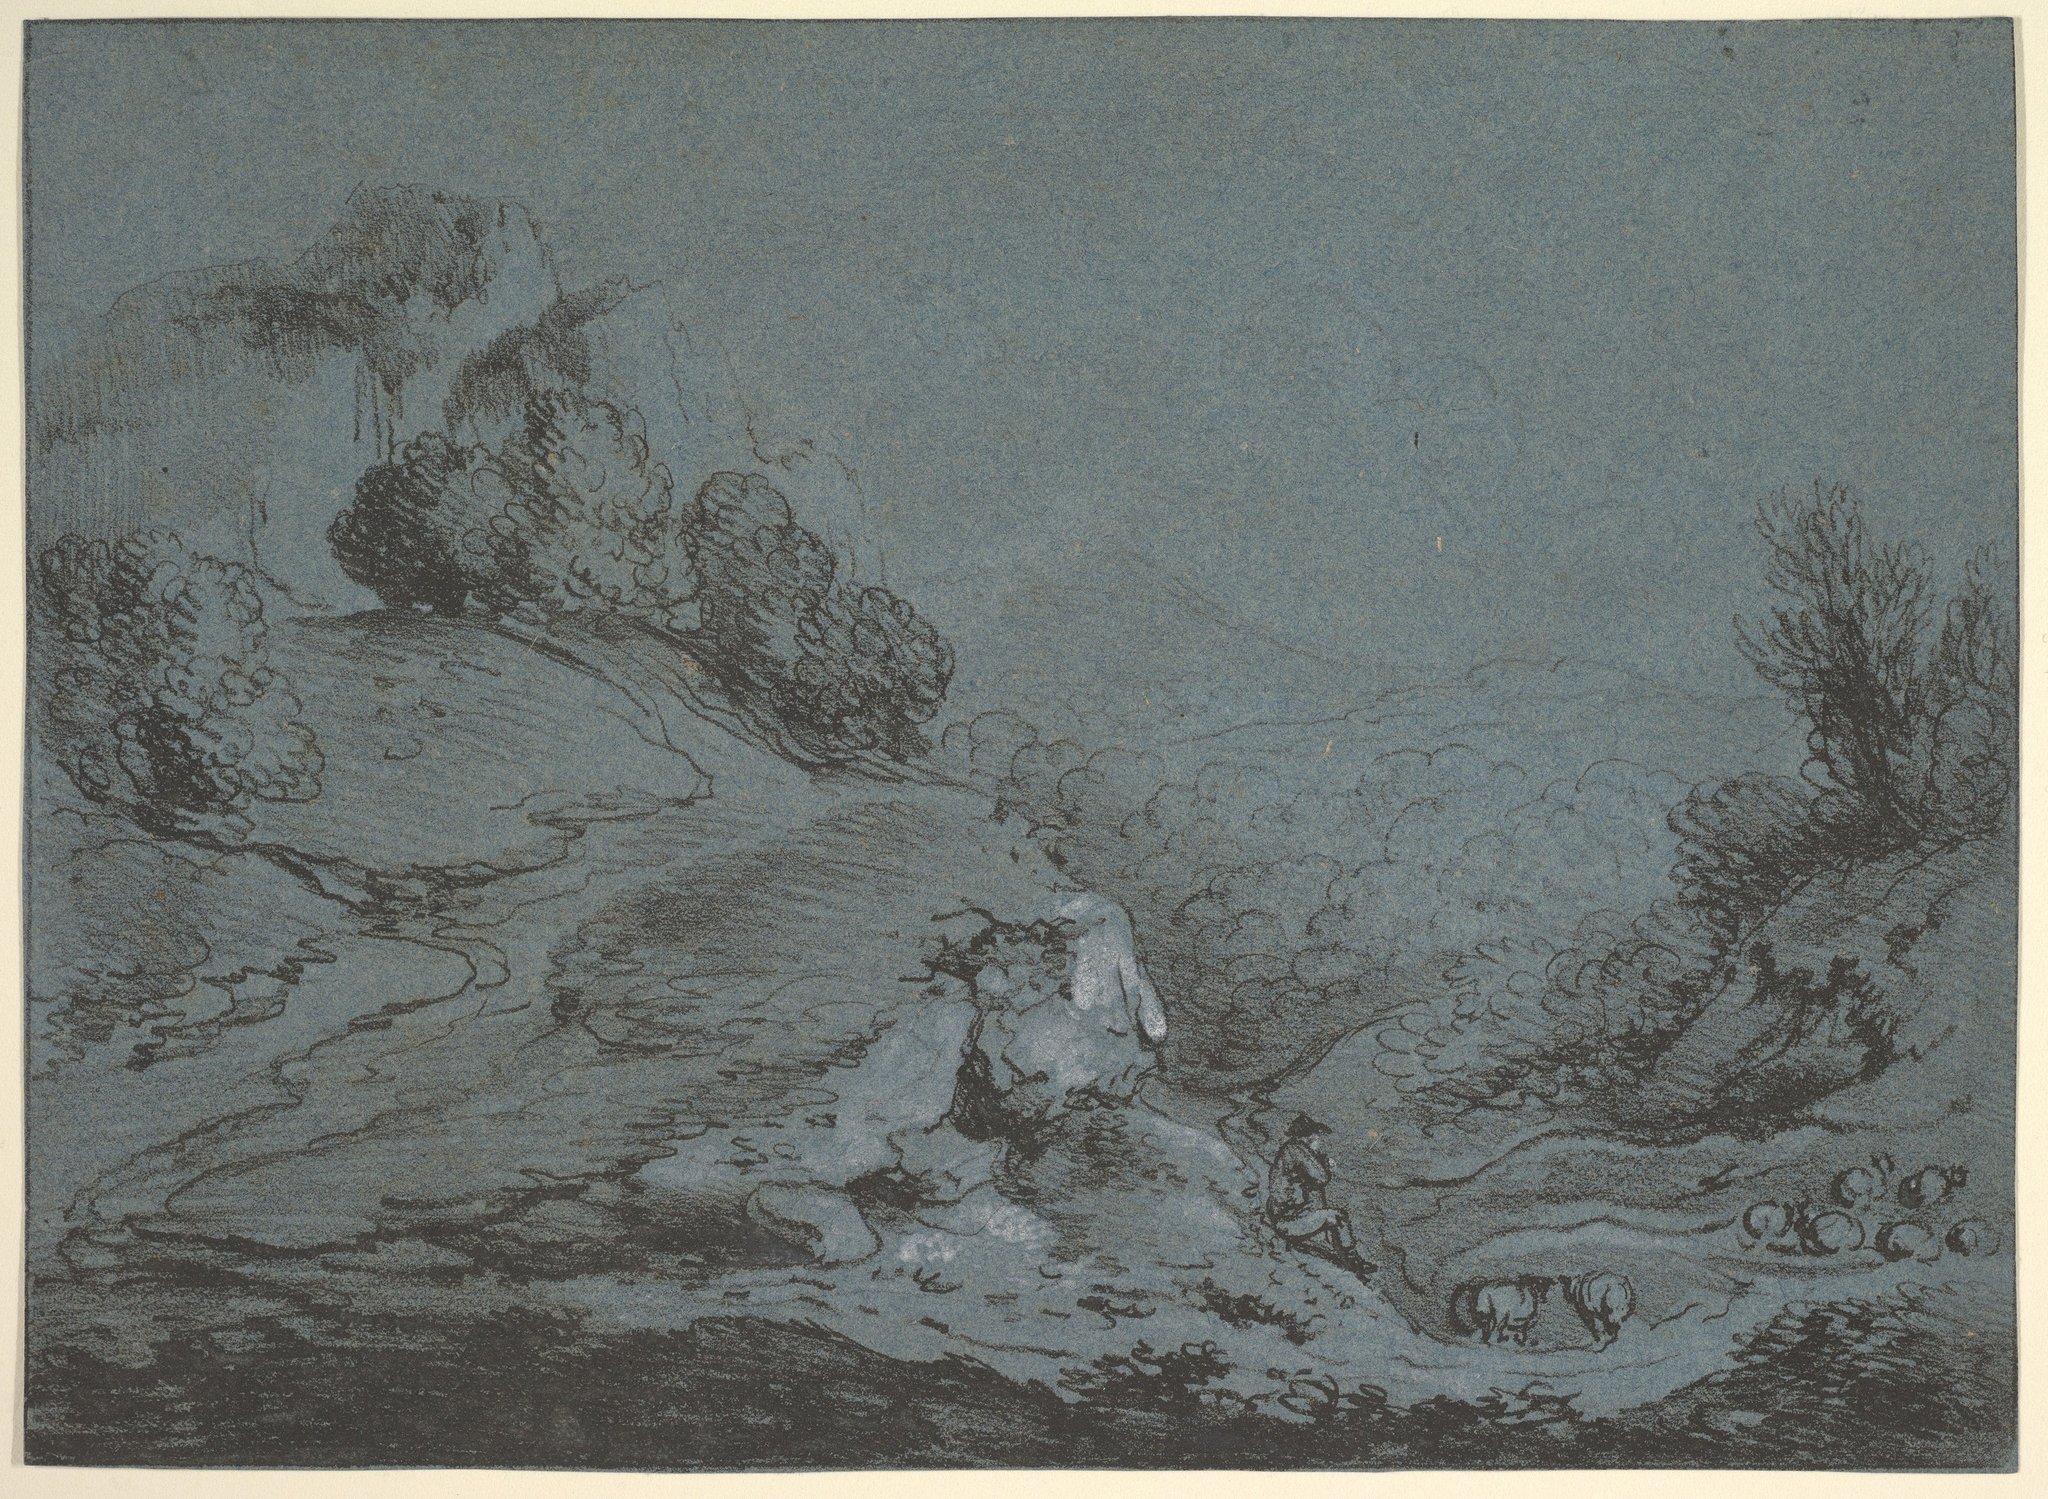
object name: print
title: Landscape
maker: thomas gainsborough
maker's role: artist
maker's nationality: british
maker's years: 1727-1788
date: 1701-1900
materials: chalk, paper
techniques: etching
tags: men,sheep,landscapes